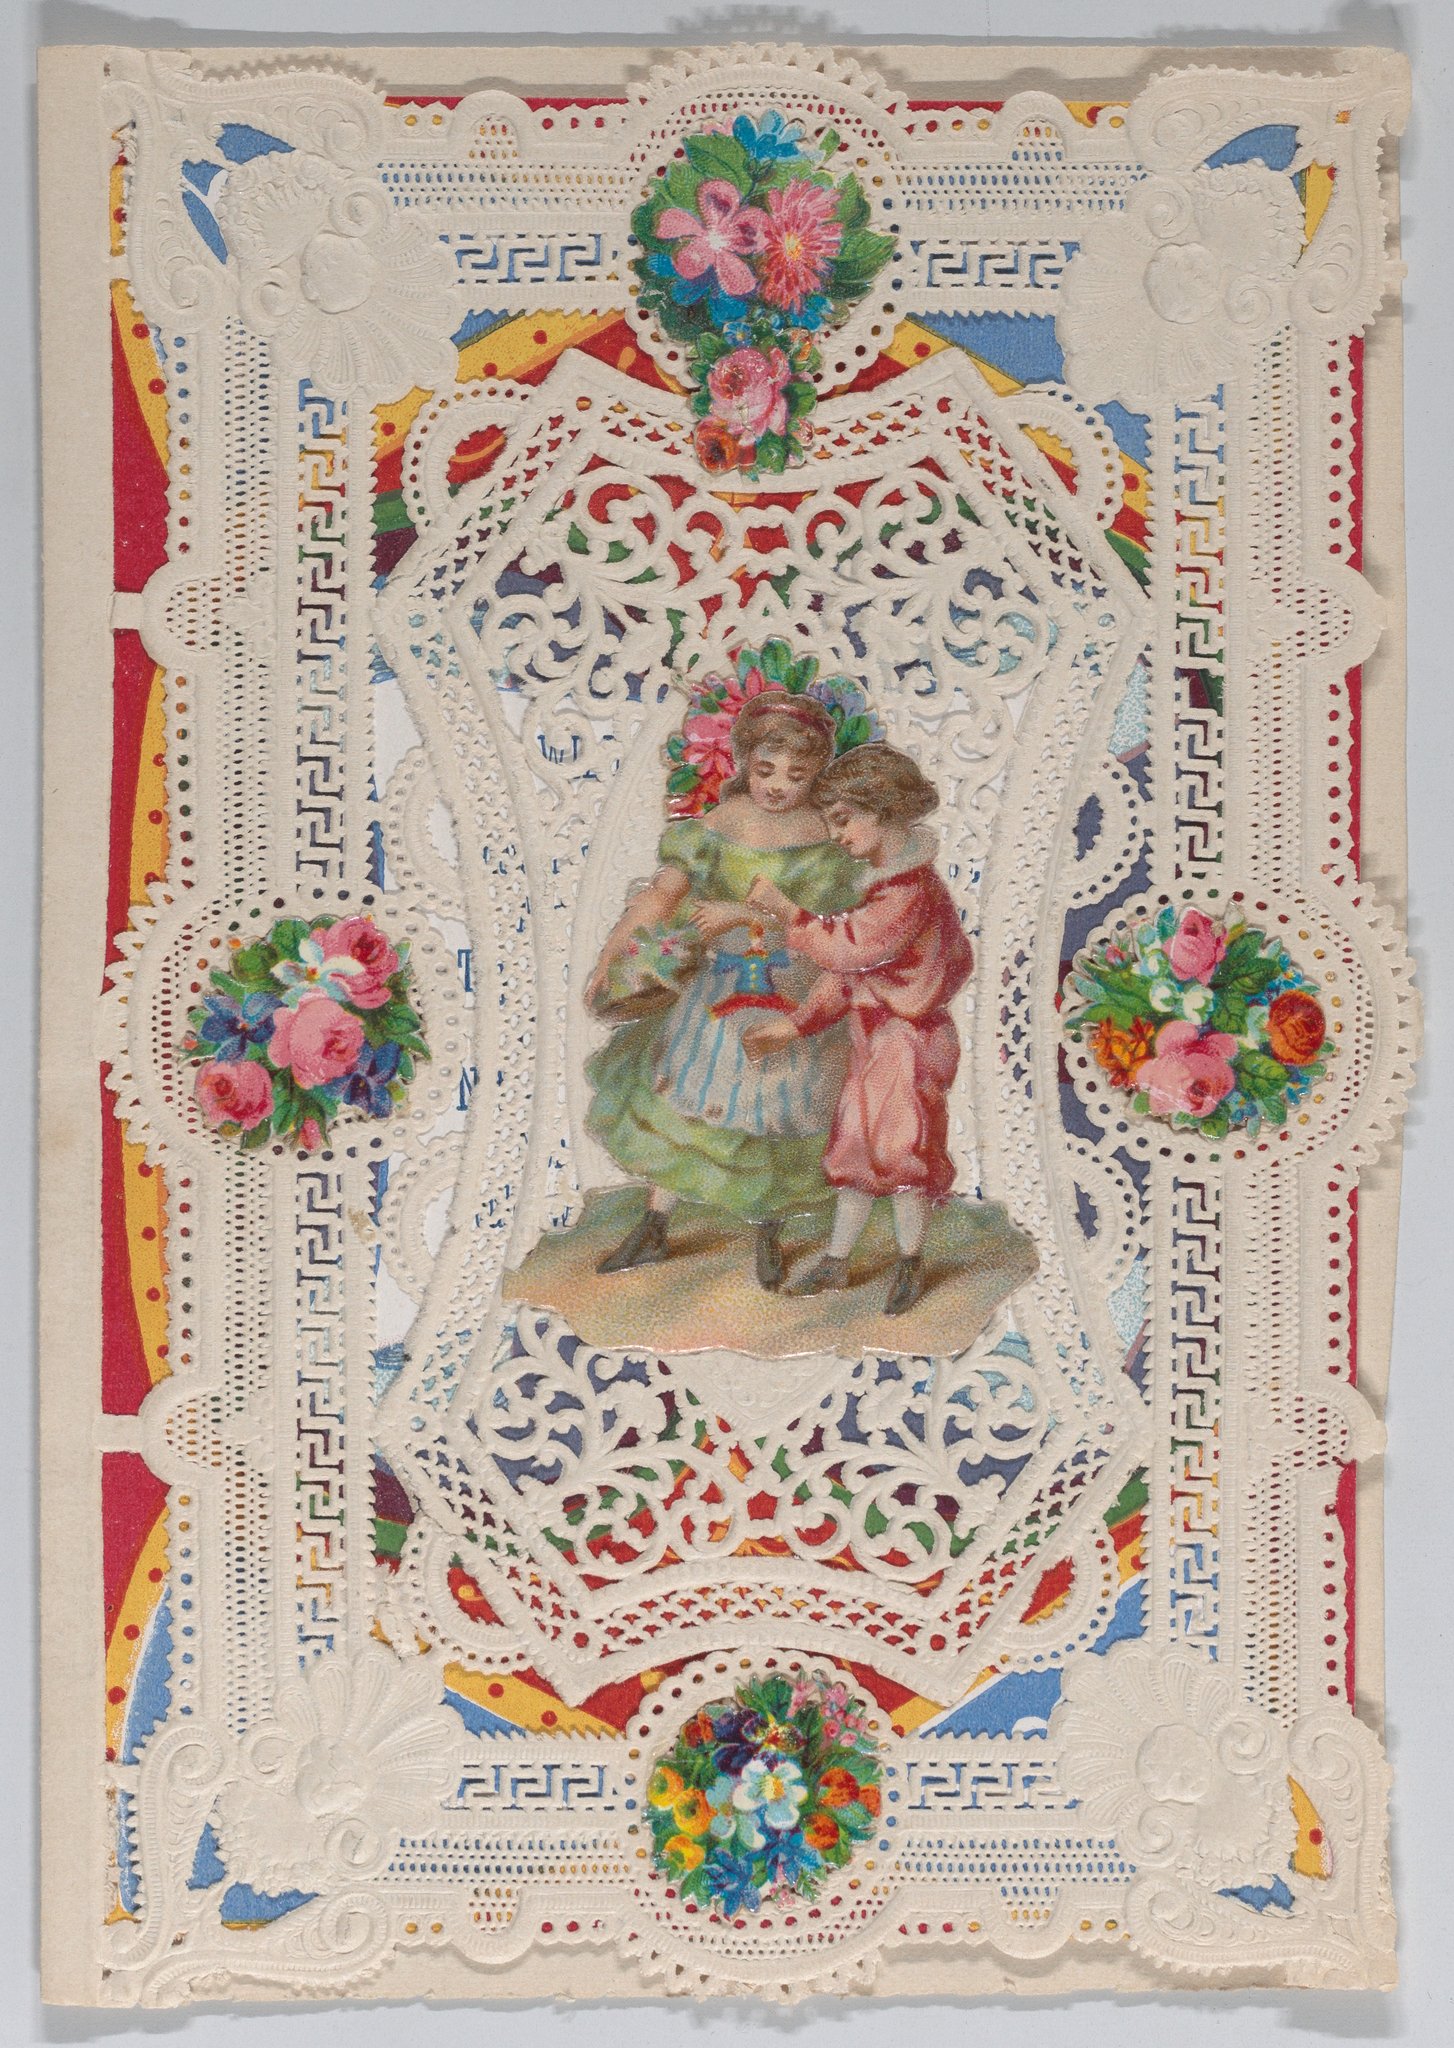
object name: valentine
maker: Anonymous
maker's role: artist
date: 1880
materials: lace, paper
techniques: chromolithography, embossing, open work